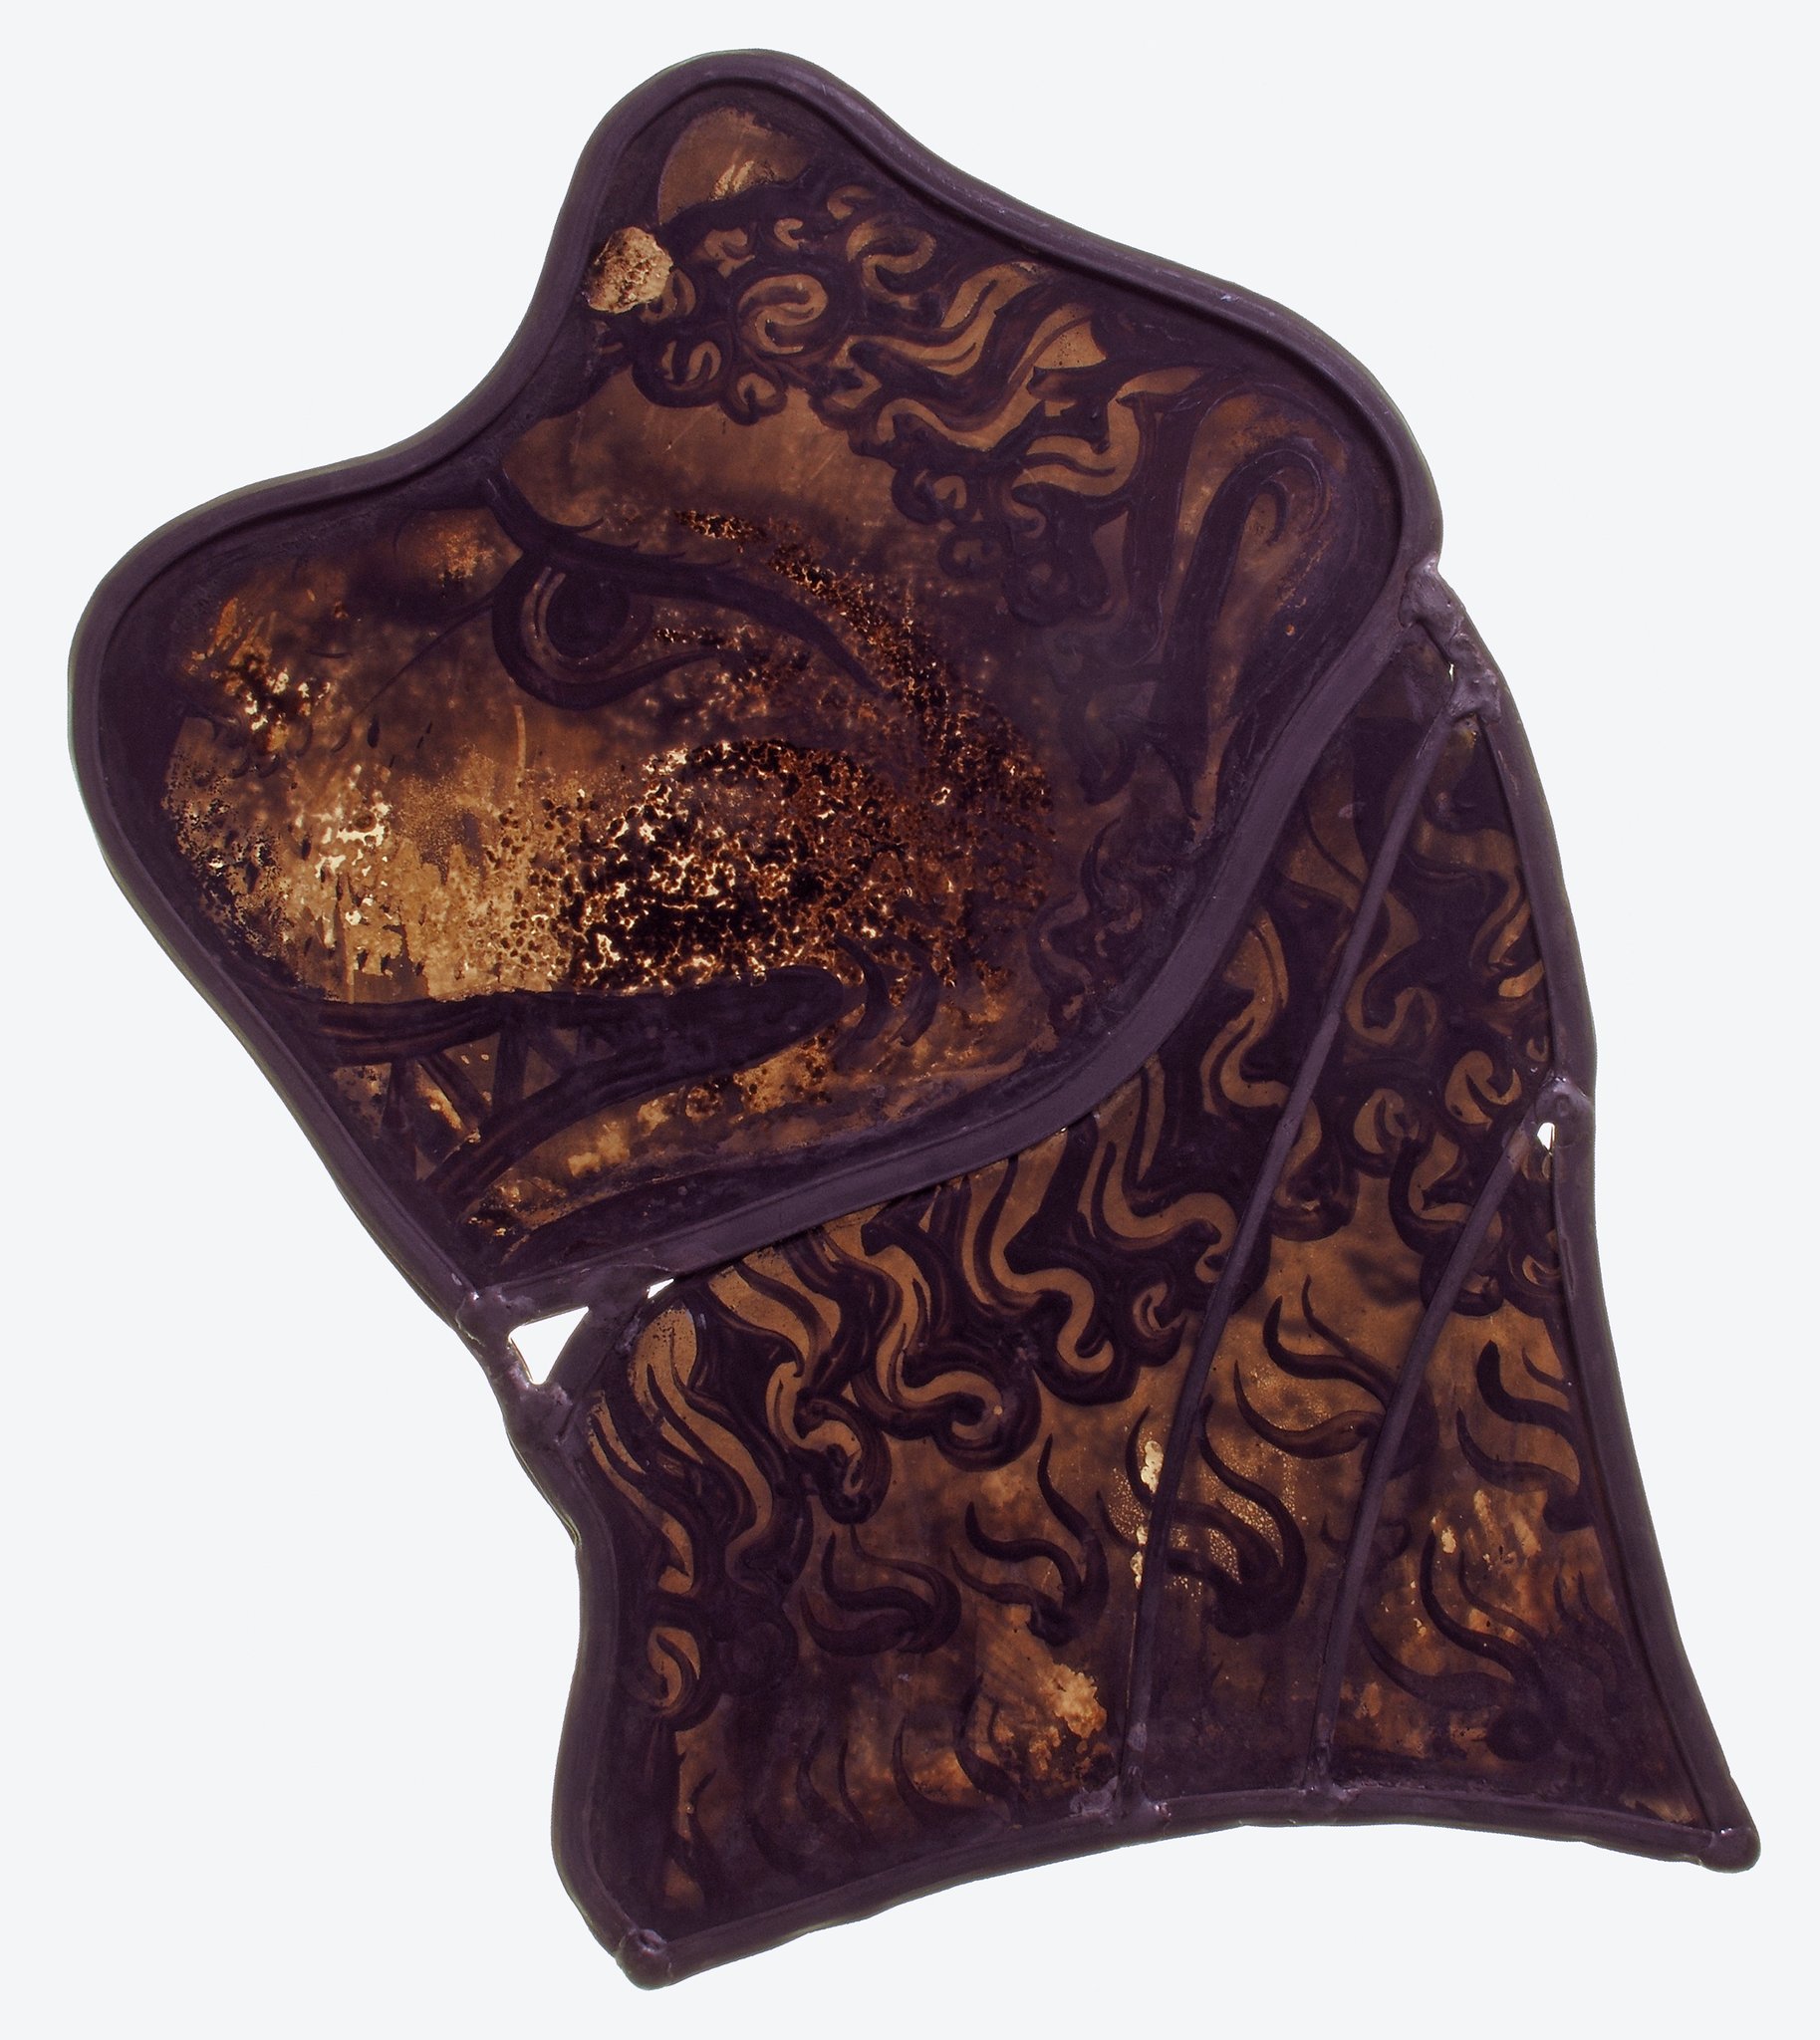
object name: fragment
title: Glass Fragment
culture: european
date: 1401-1500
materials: glass, metal